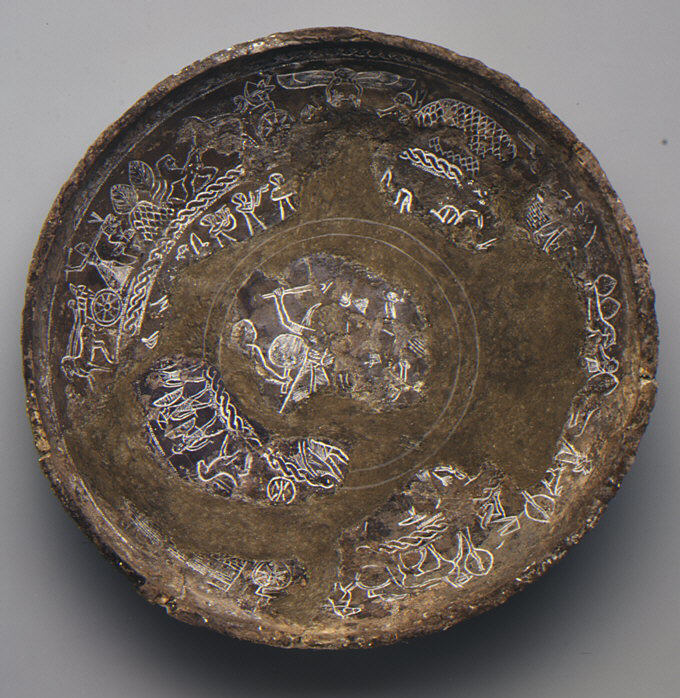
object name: bowl with medallion of egyptian figure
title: Fragmentary silver bowl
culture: cypriot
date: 710-675 BCE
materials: silver